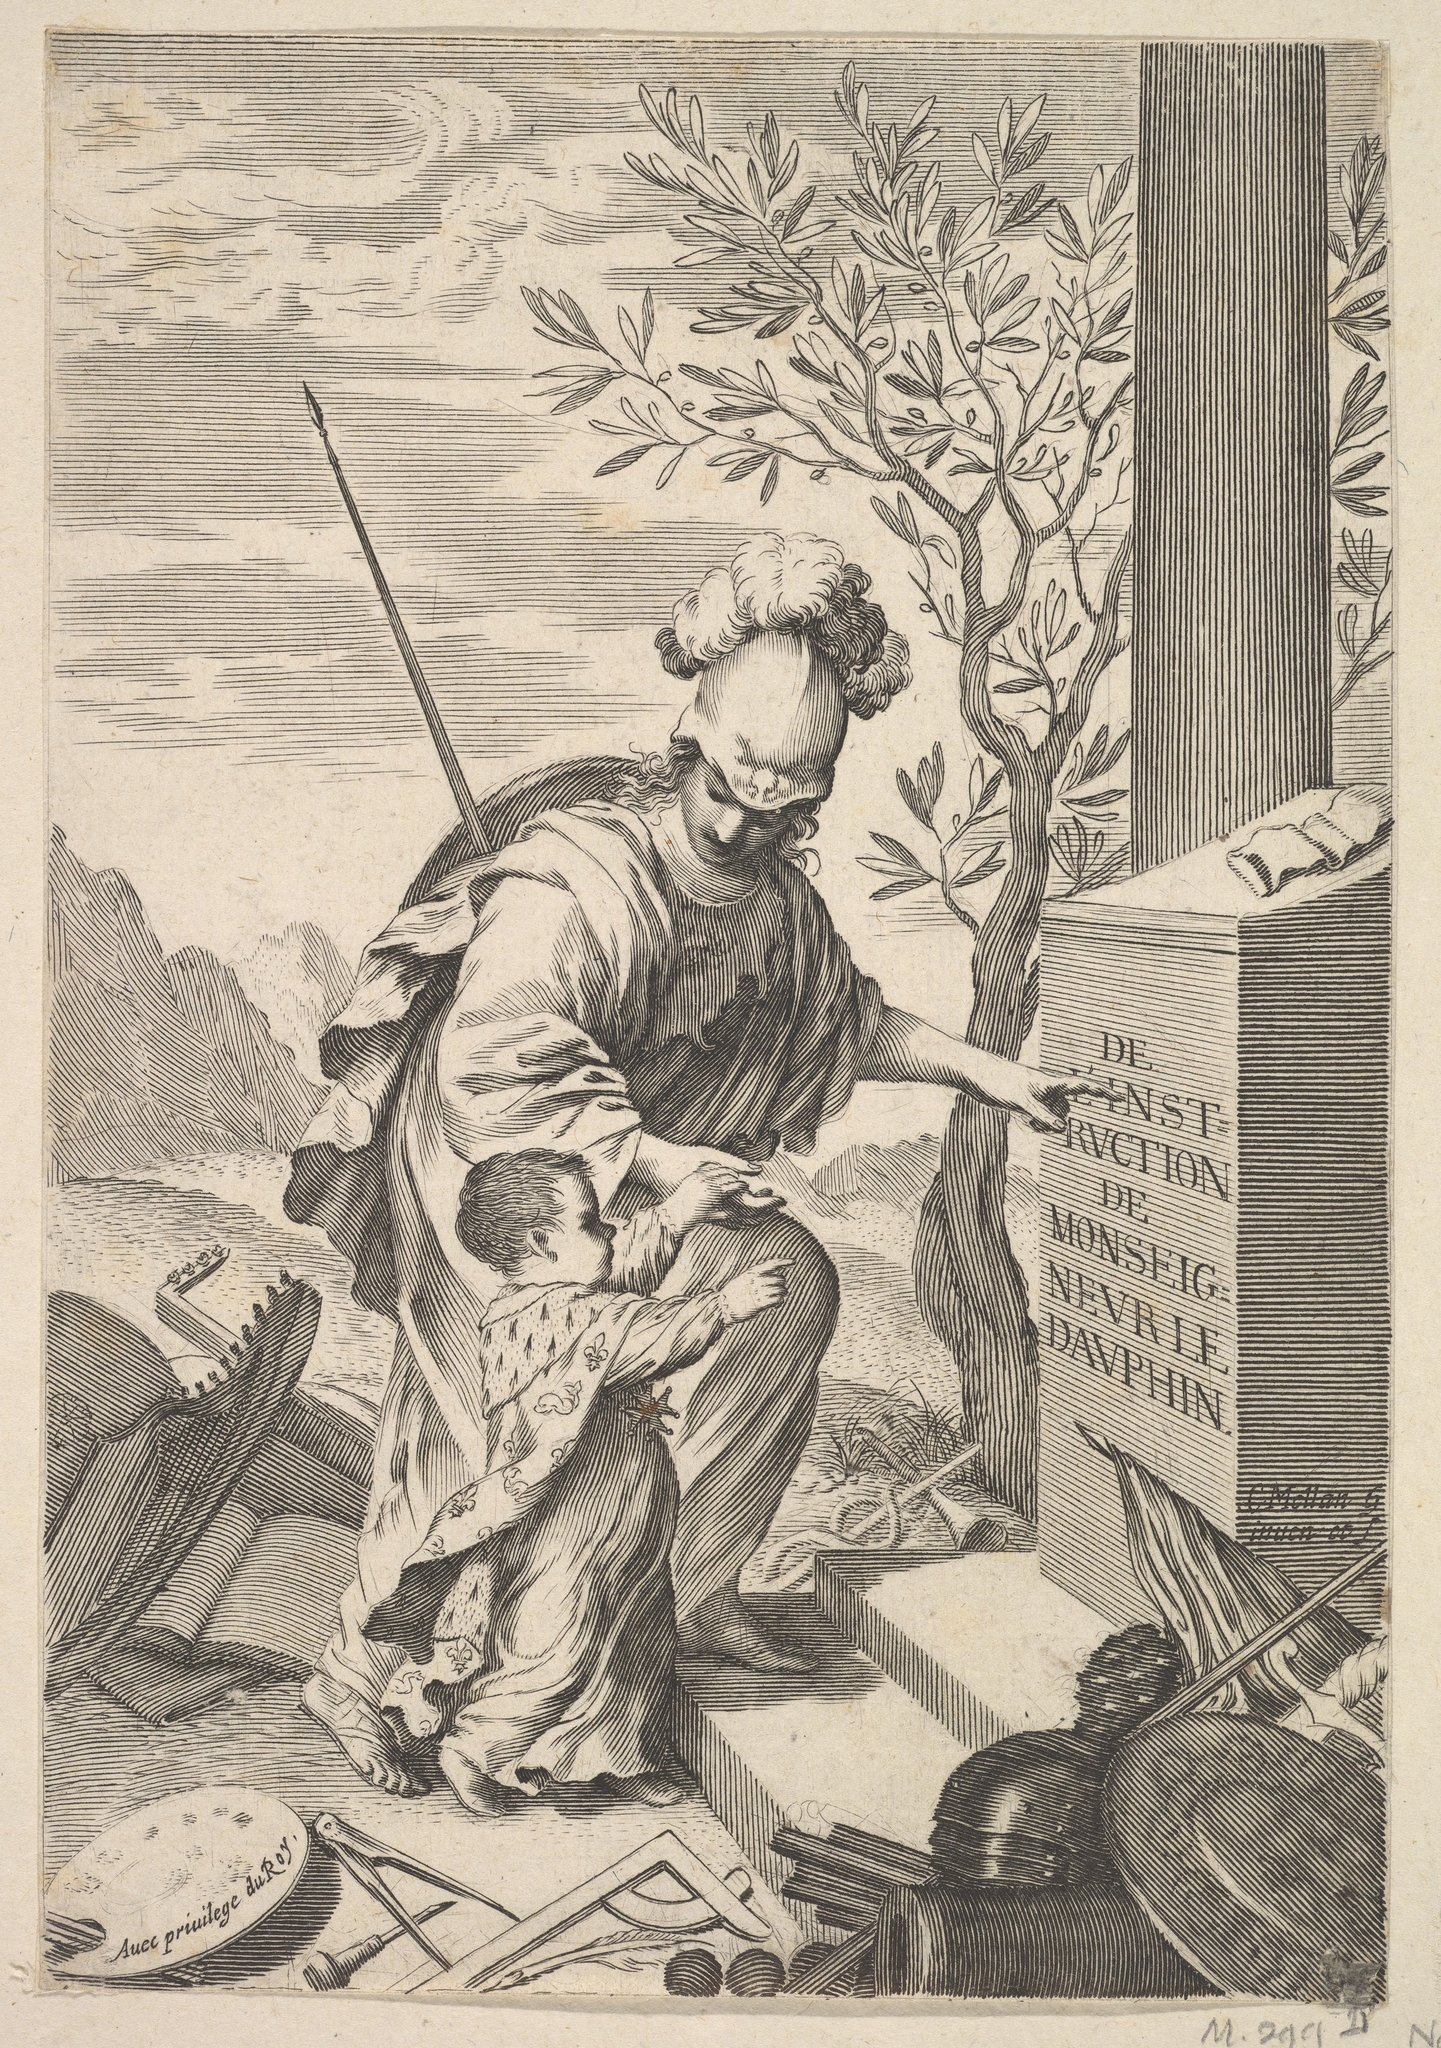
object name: print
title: Minerva Instructs the Dauphin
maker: claude mellan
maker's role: artist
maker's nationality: french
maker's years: 1598-1688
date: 1640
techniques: engraving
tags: minerva